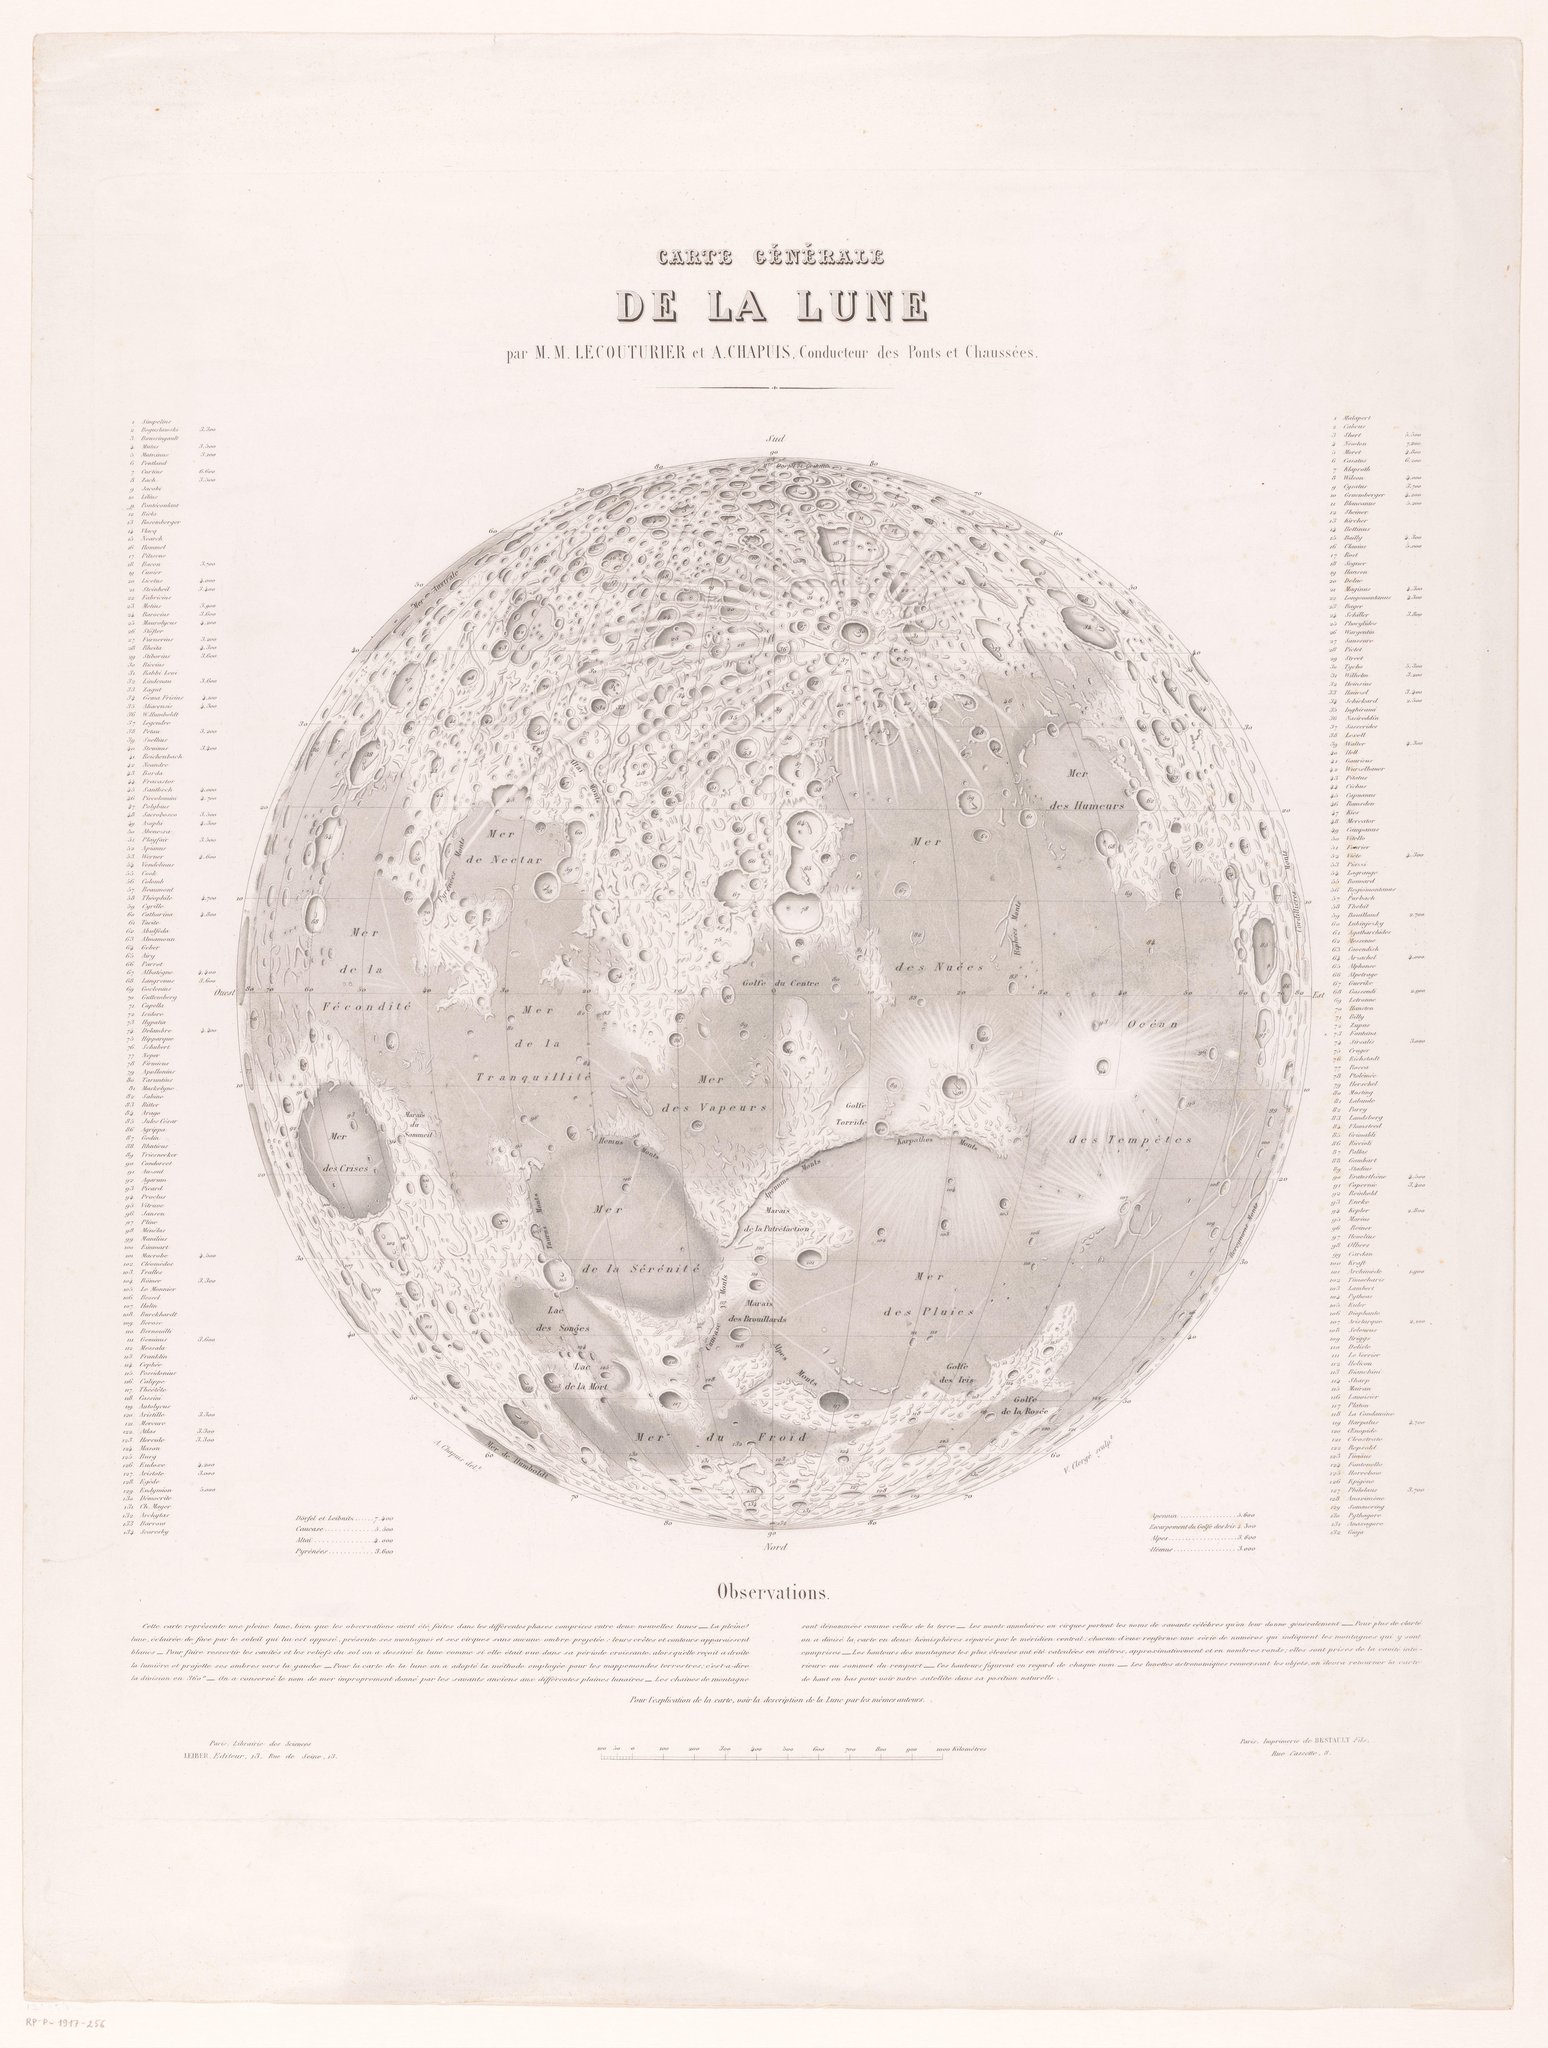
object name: print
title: Carte générale de la lune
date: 1860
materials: paper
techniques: engraving, etching, roulette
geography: paris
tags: moon as celestial body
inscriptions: collector's mark: Lugt 2228